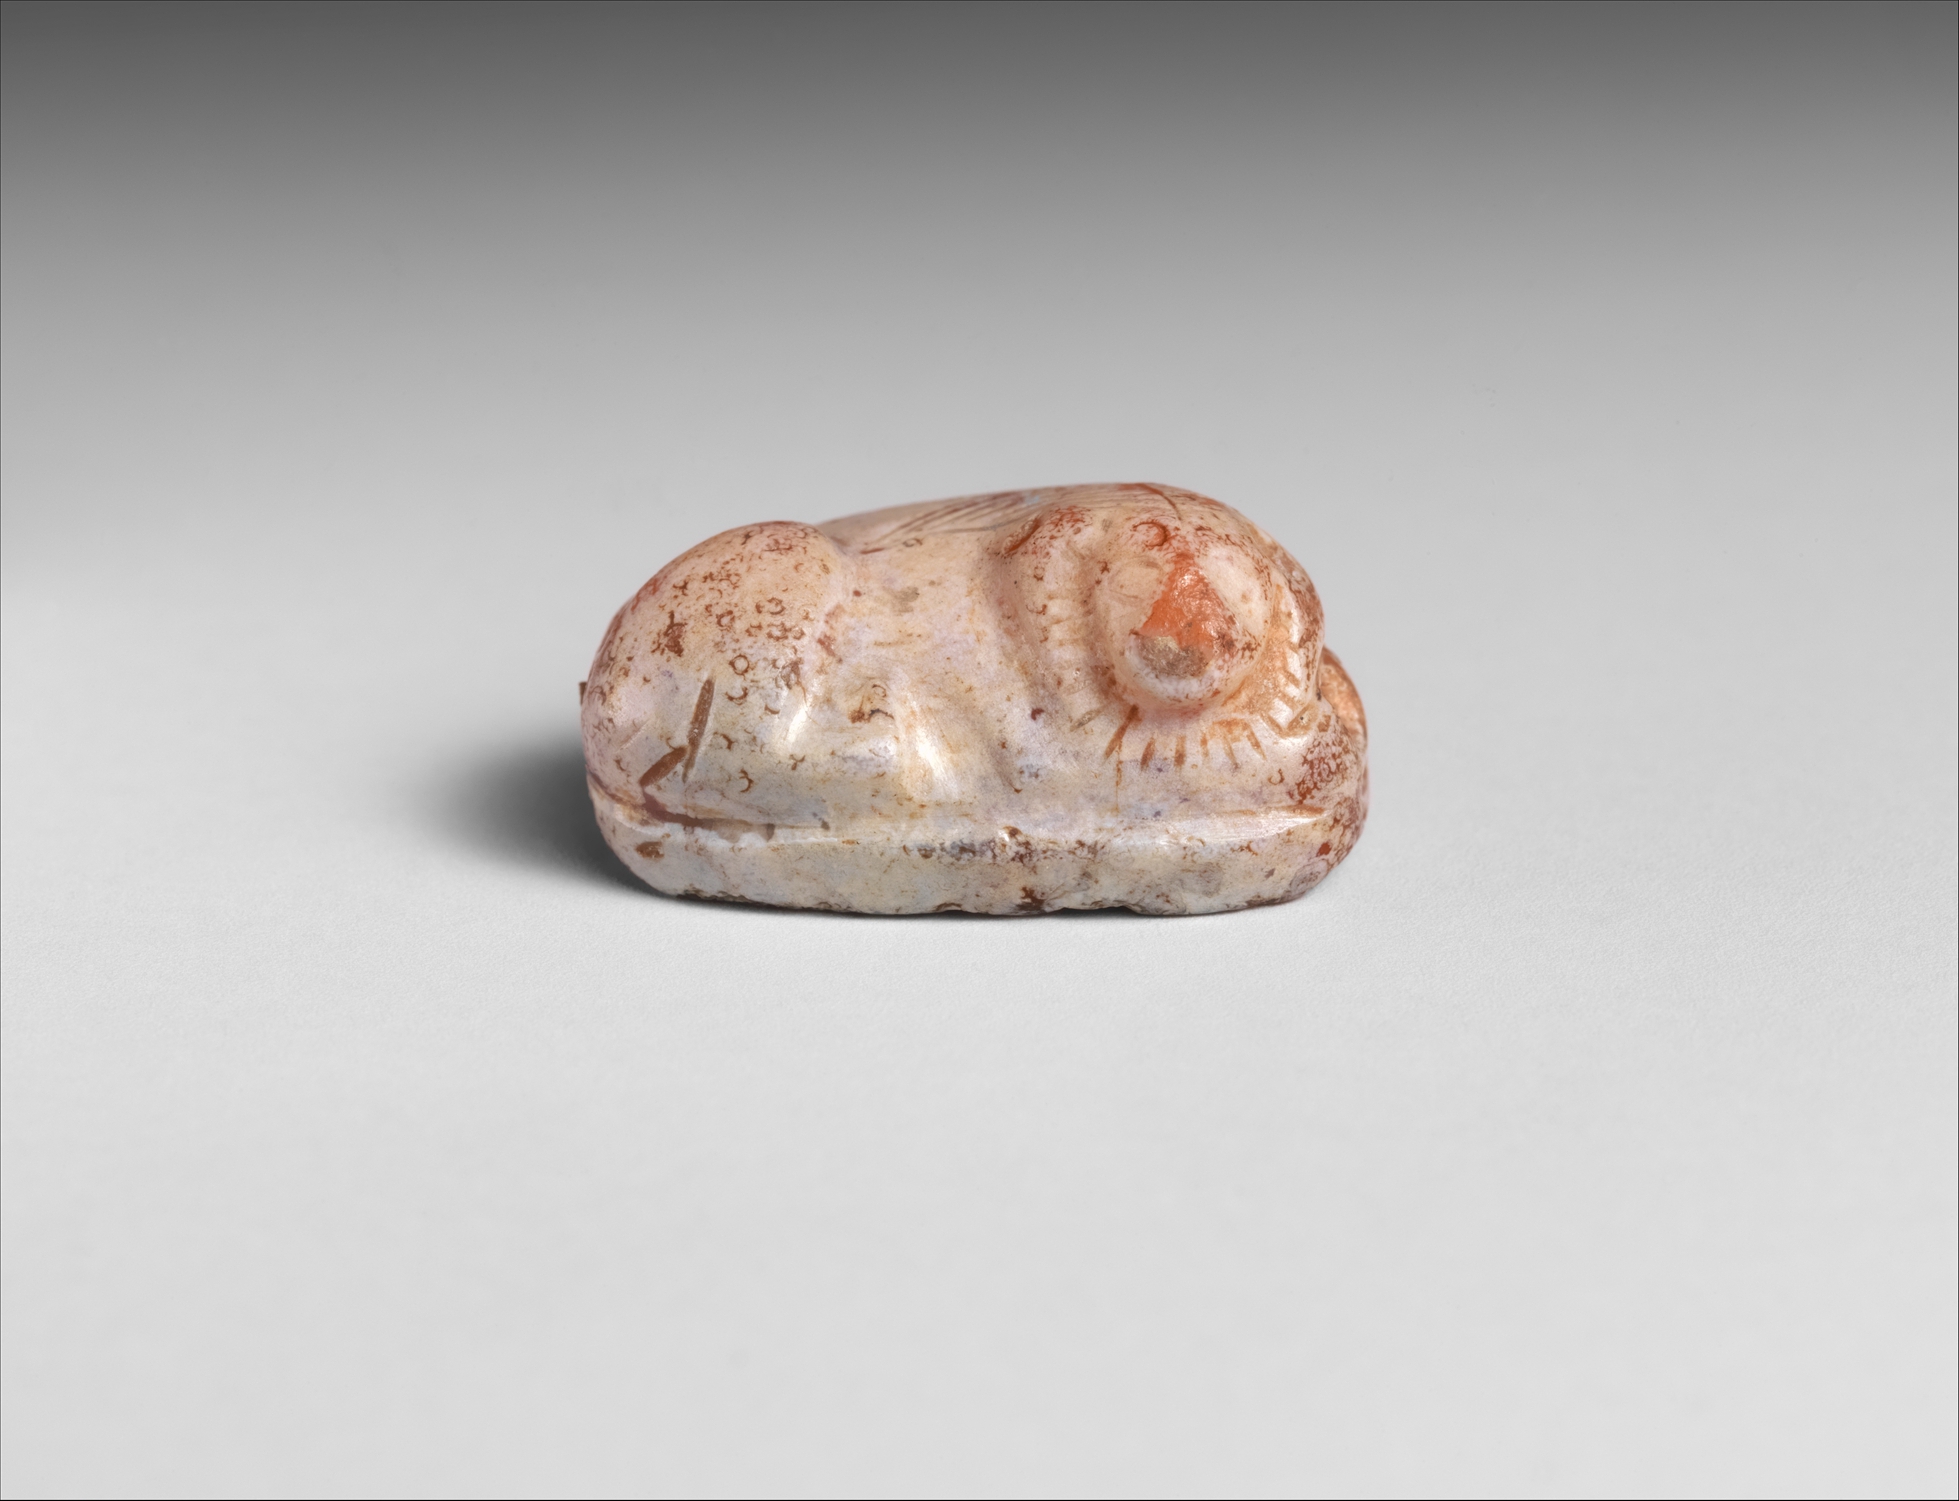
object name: scaraboid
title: Carnelian scaraboid with back in form of lion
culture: greek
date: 434-401 BCE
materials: gemstone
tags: lions